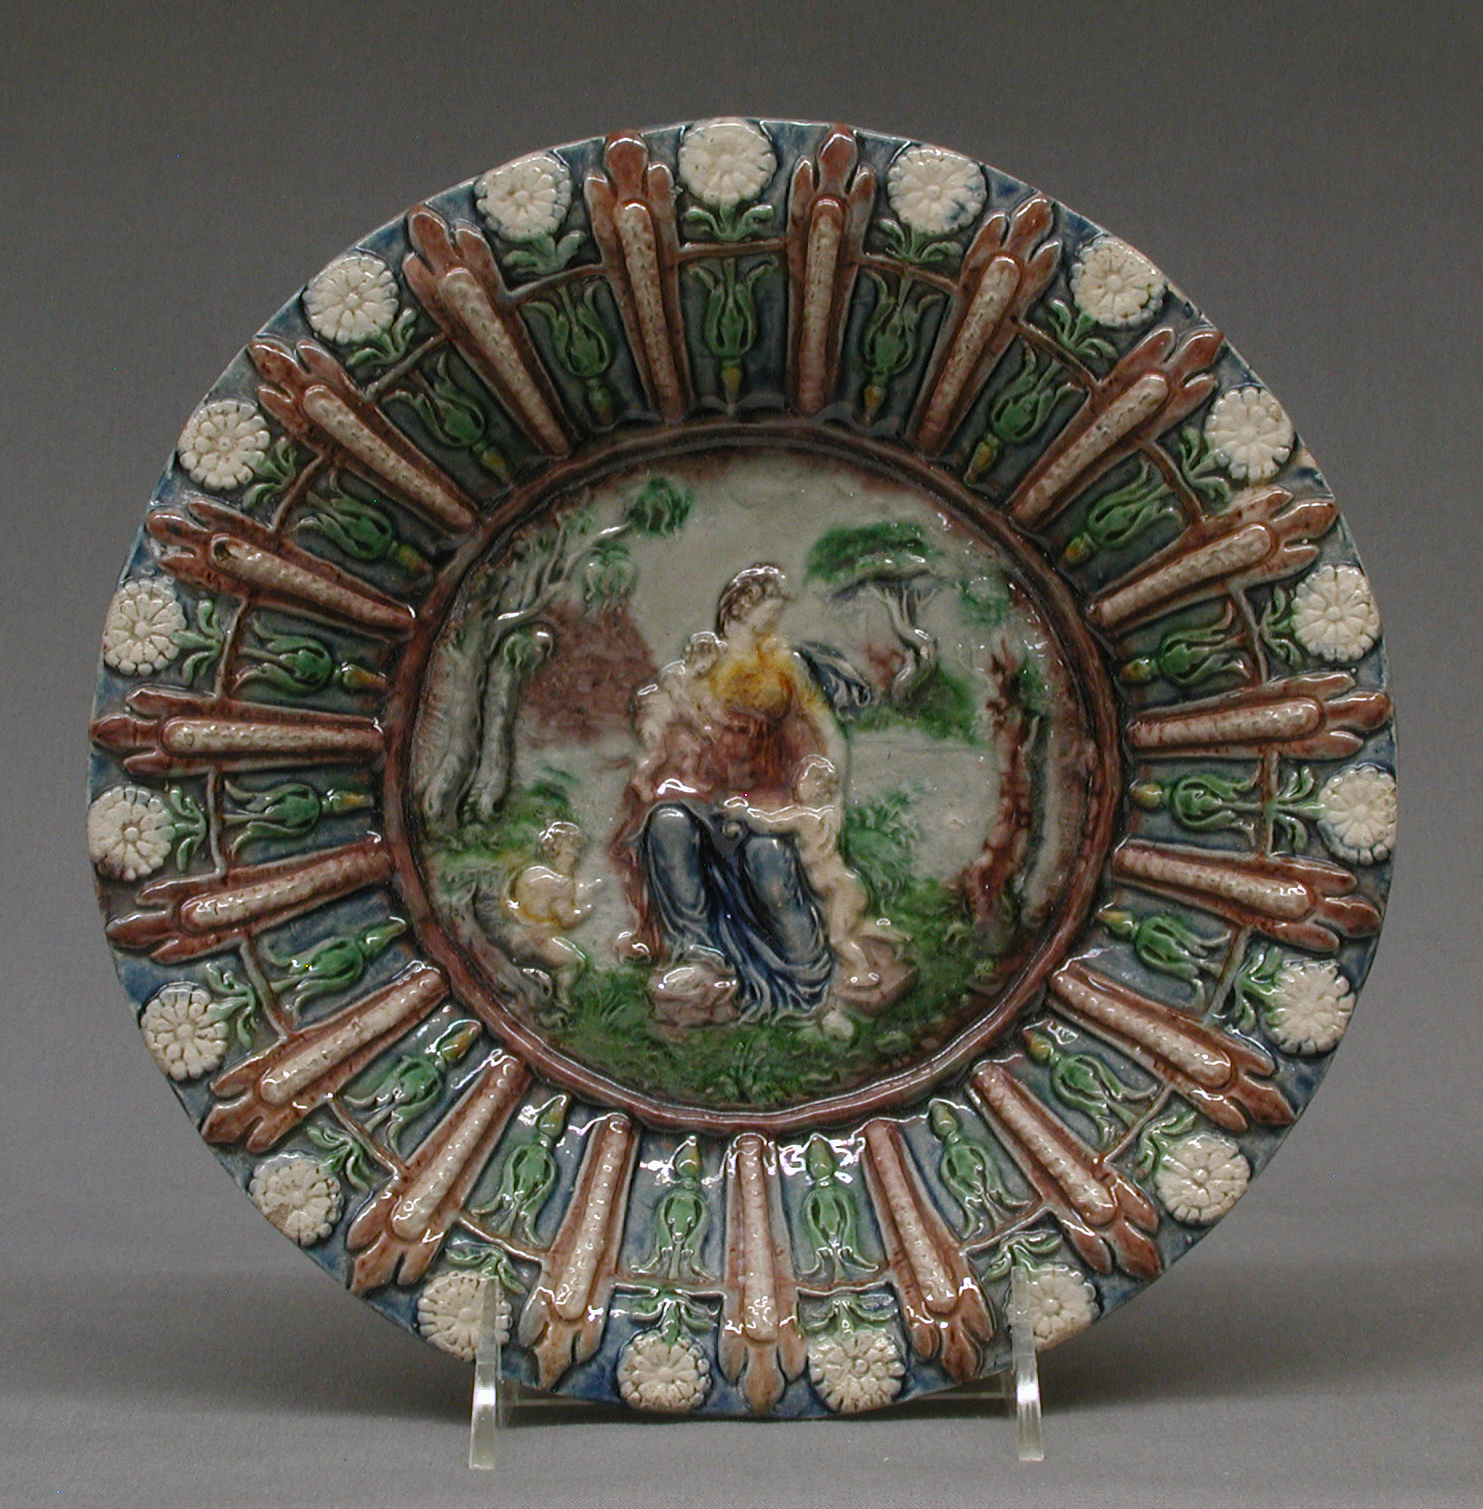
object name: dish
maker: bernard palissy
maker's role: maker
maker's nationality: french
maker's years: 1510-1590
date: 1801-1900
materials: earthenware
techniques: glazing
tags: children,women,flowers